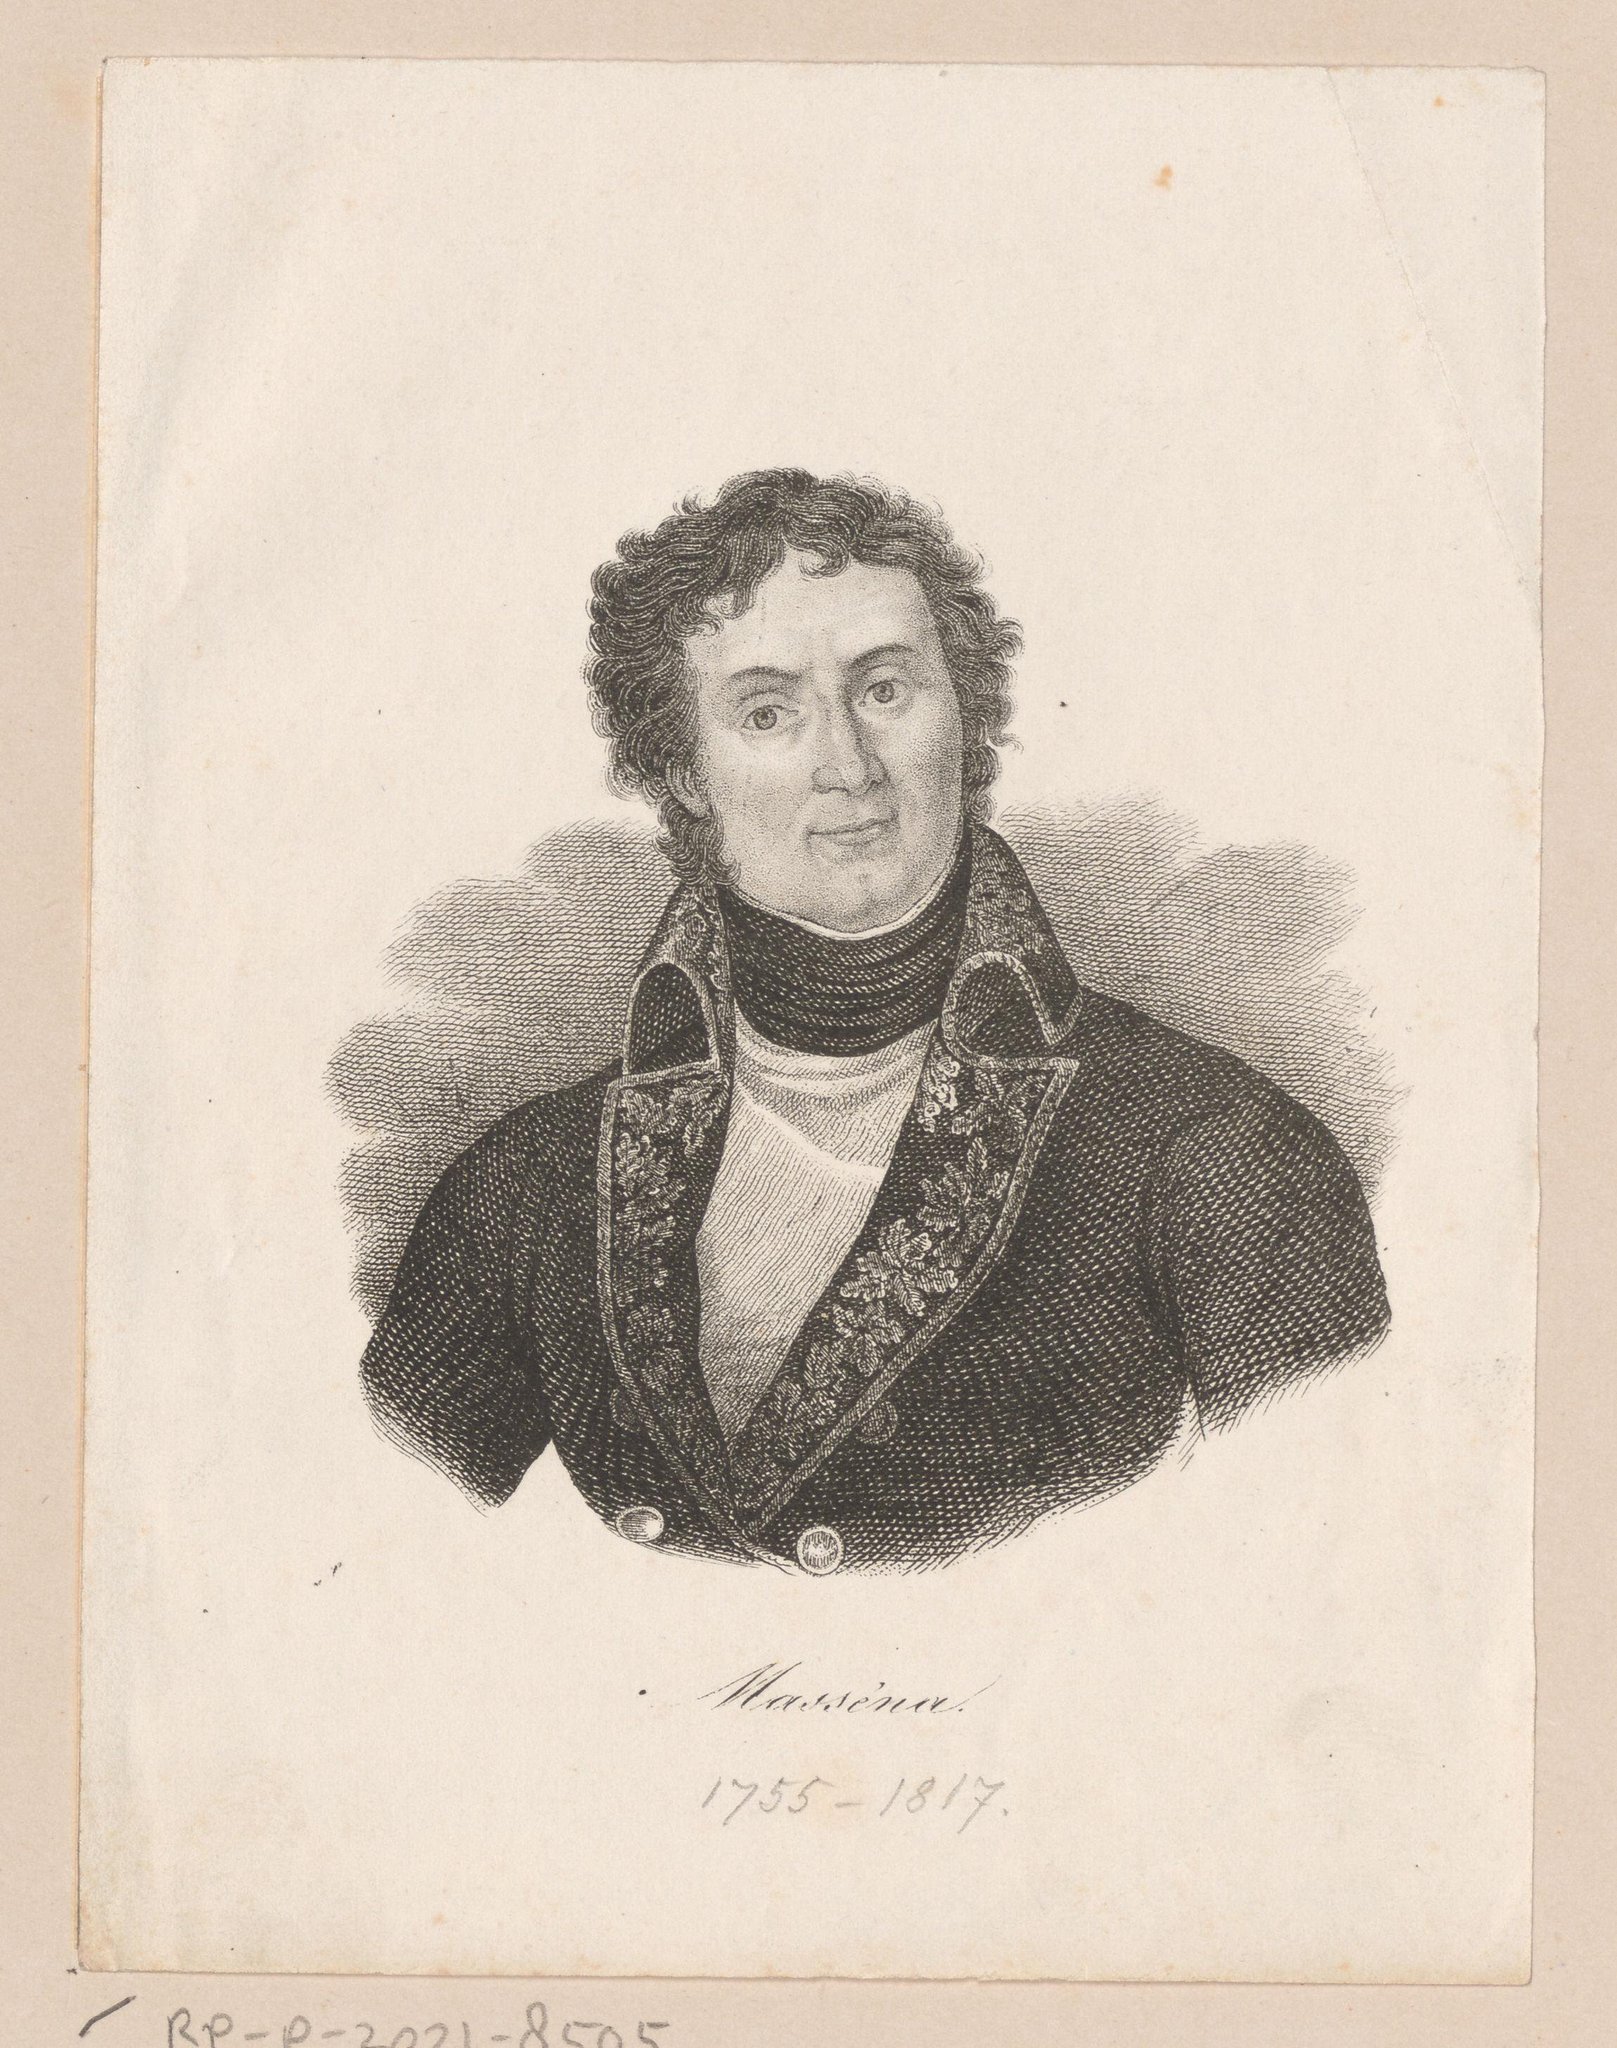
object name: print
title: Portret van André Masséna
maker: Anonymous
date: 1800-1899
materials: paper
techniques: lithograph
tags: commander-in-chief, general, marshal, historical persons